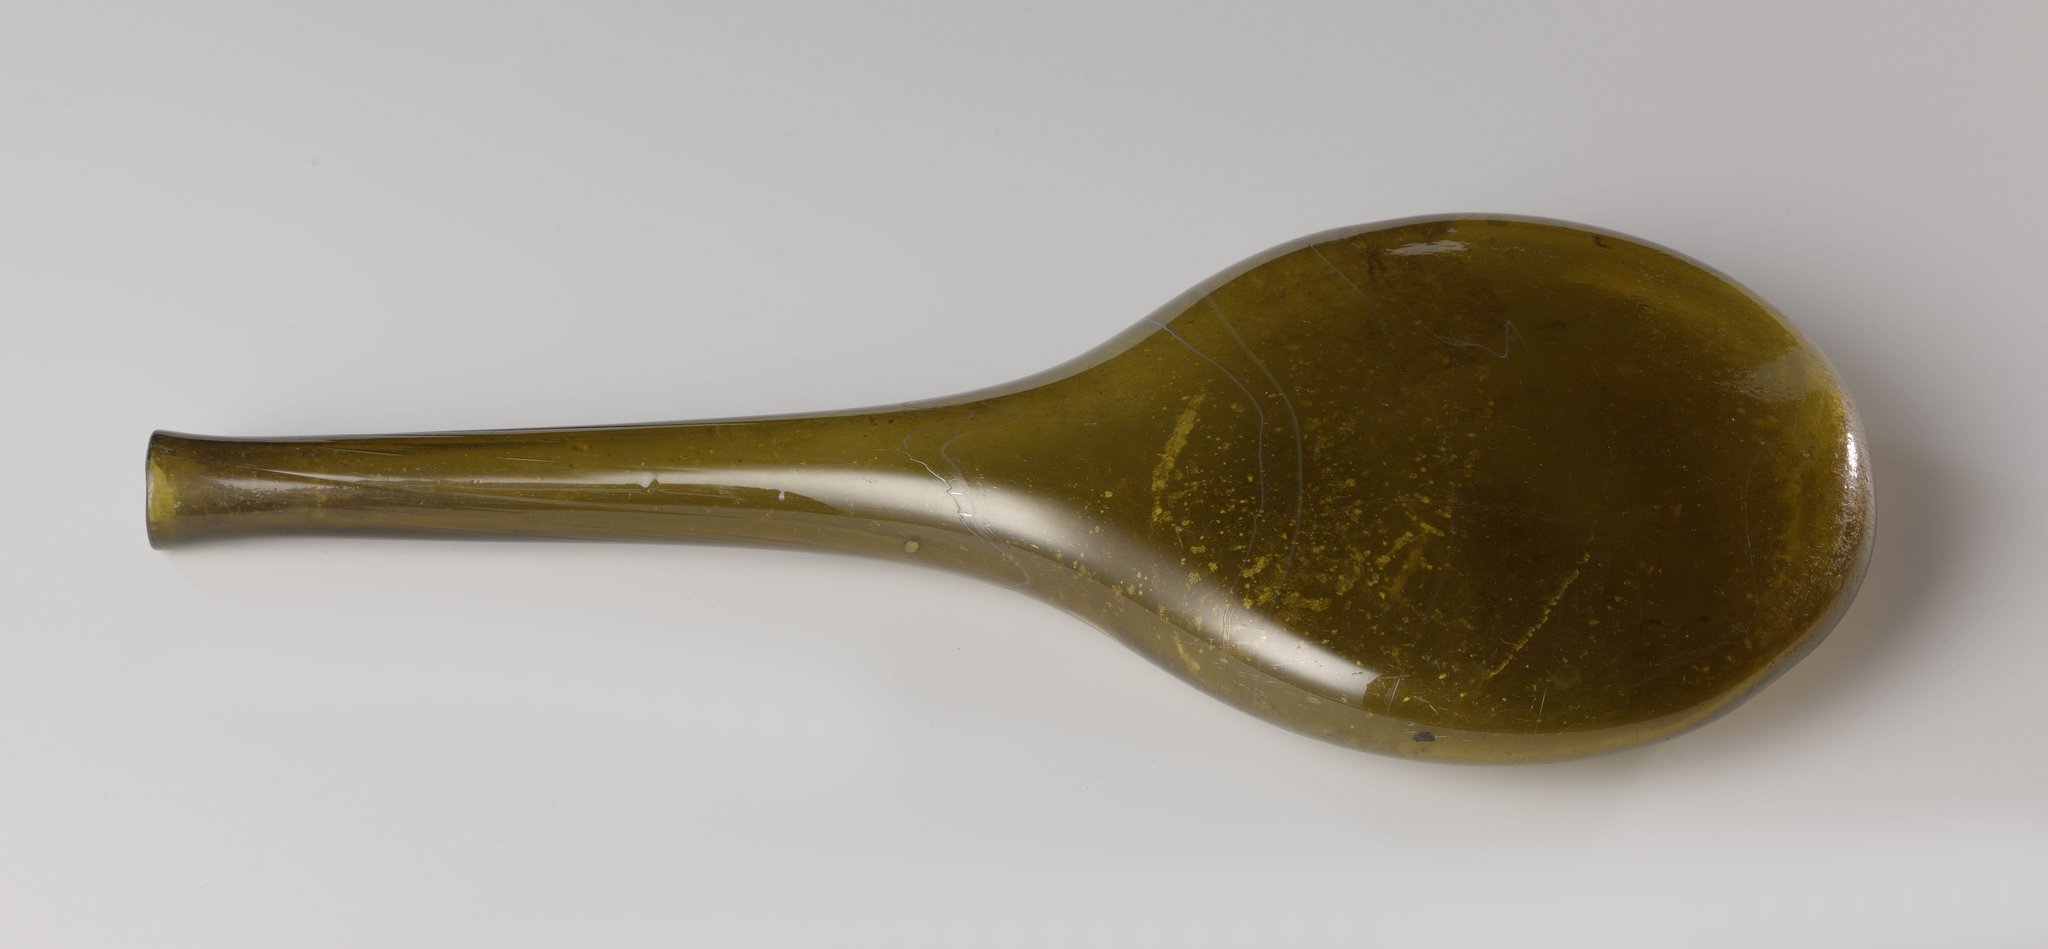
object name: spawaterfles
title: Spawaterfles met afgeplat, bolvormig lichaam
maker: Anonymous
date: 1600-1699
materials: glass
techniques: glassblowing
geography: southern netherlands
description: Bolvormig plat lichaam, overgaand in een hoge slanke hals.